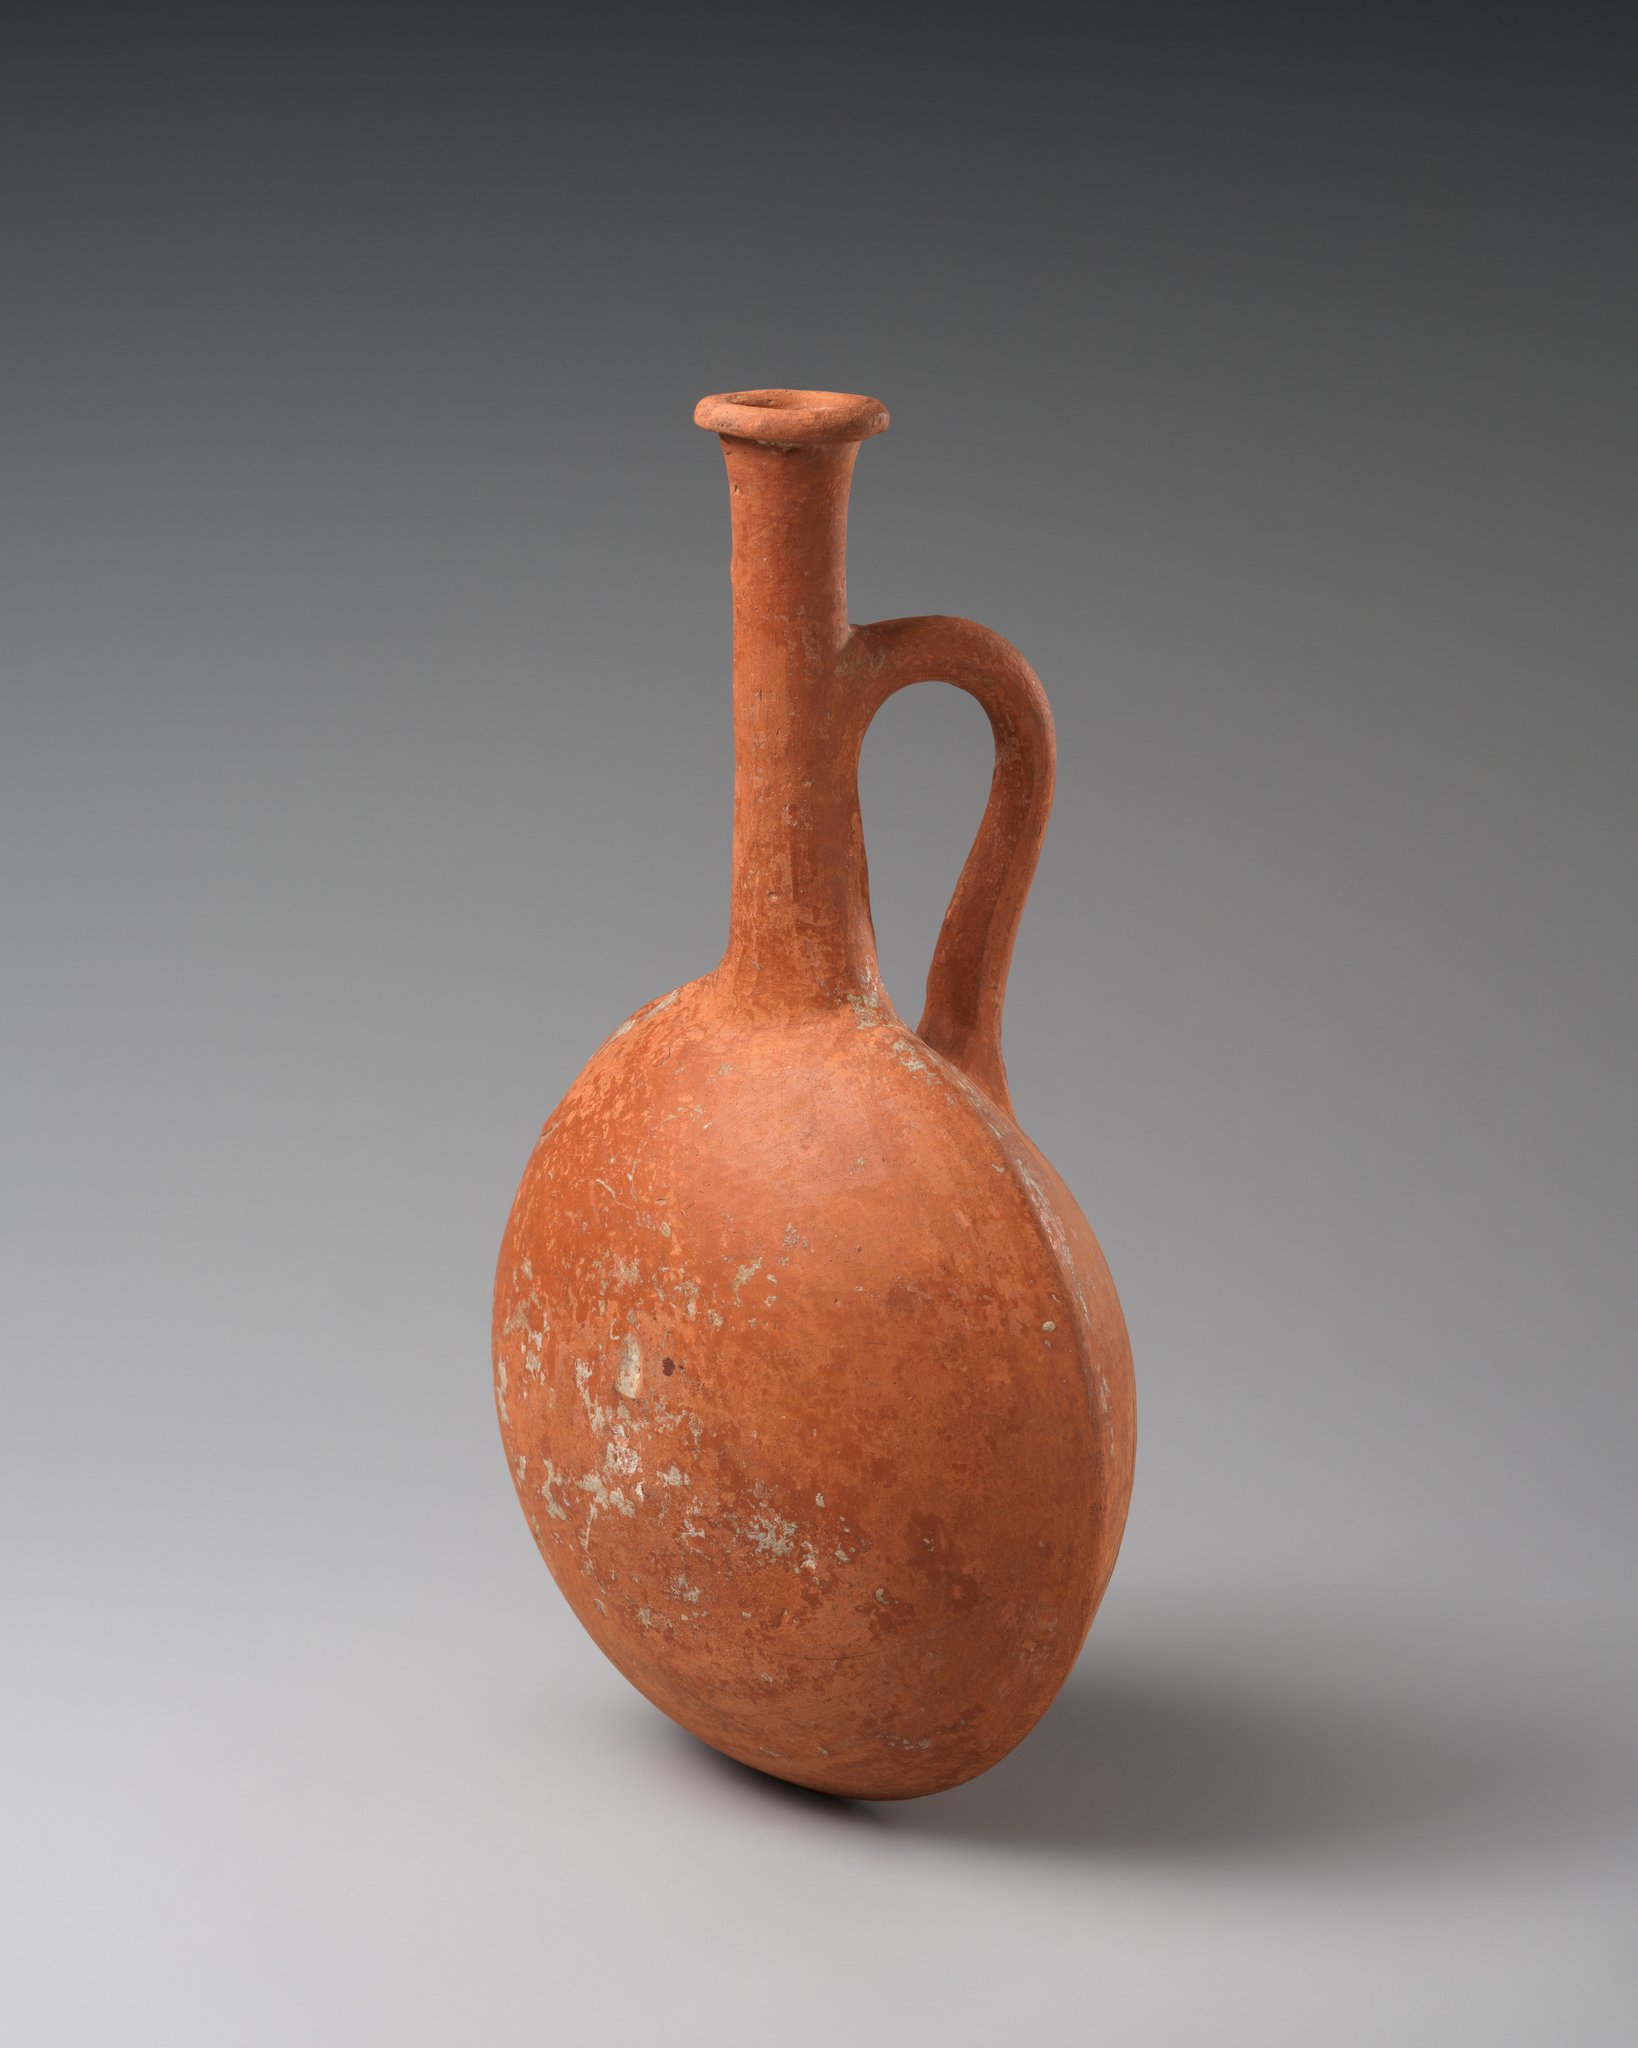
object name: flask, lentoid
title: Terracotta lentoid flask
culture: cypriot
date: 1600-1050 BCE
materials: terracotta